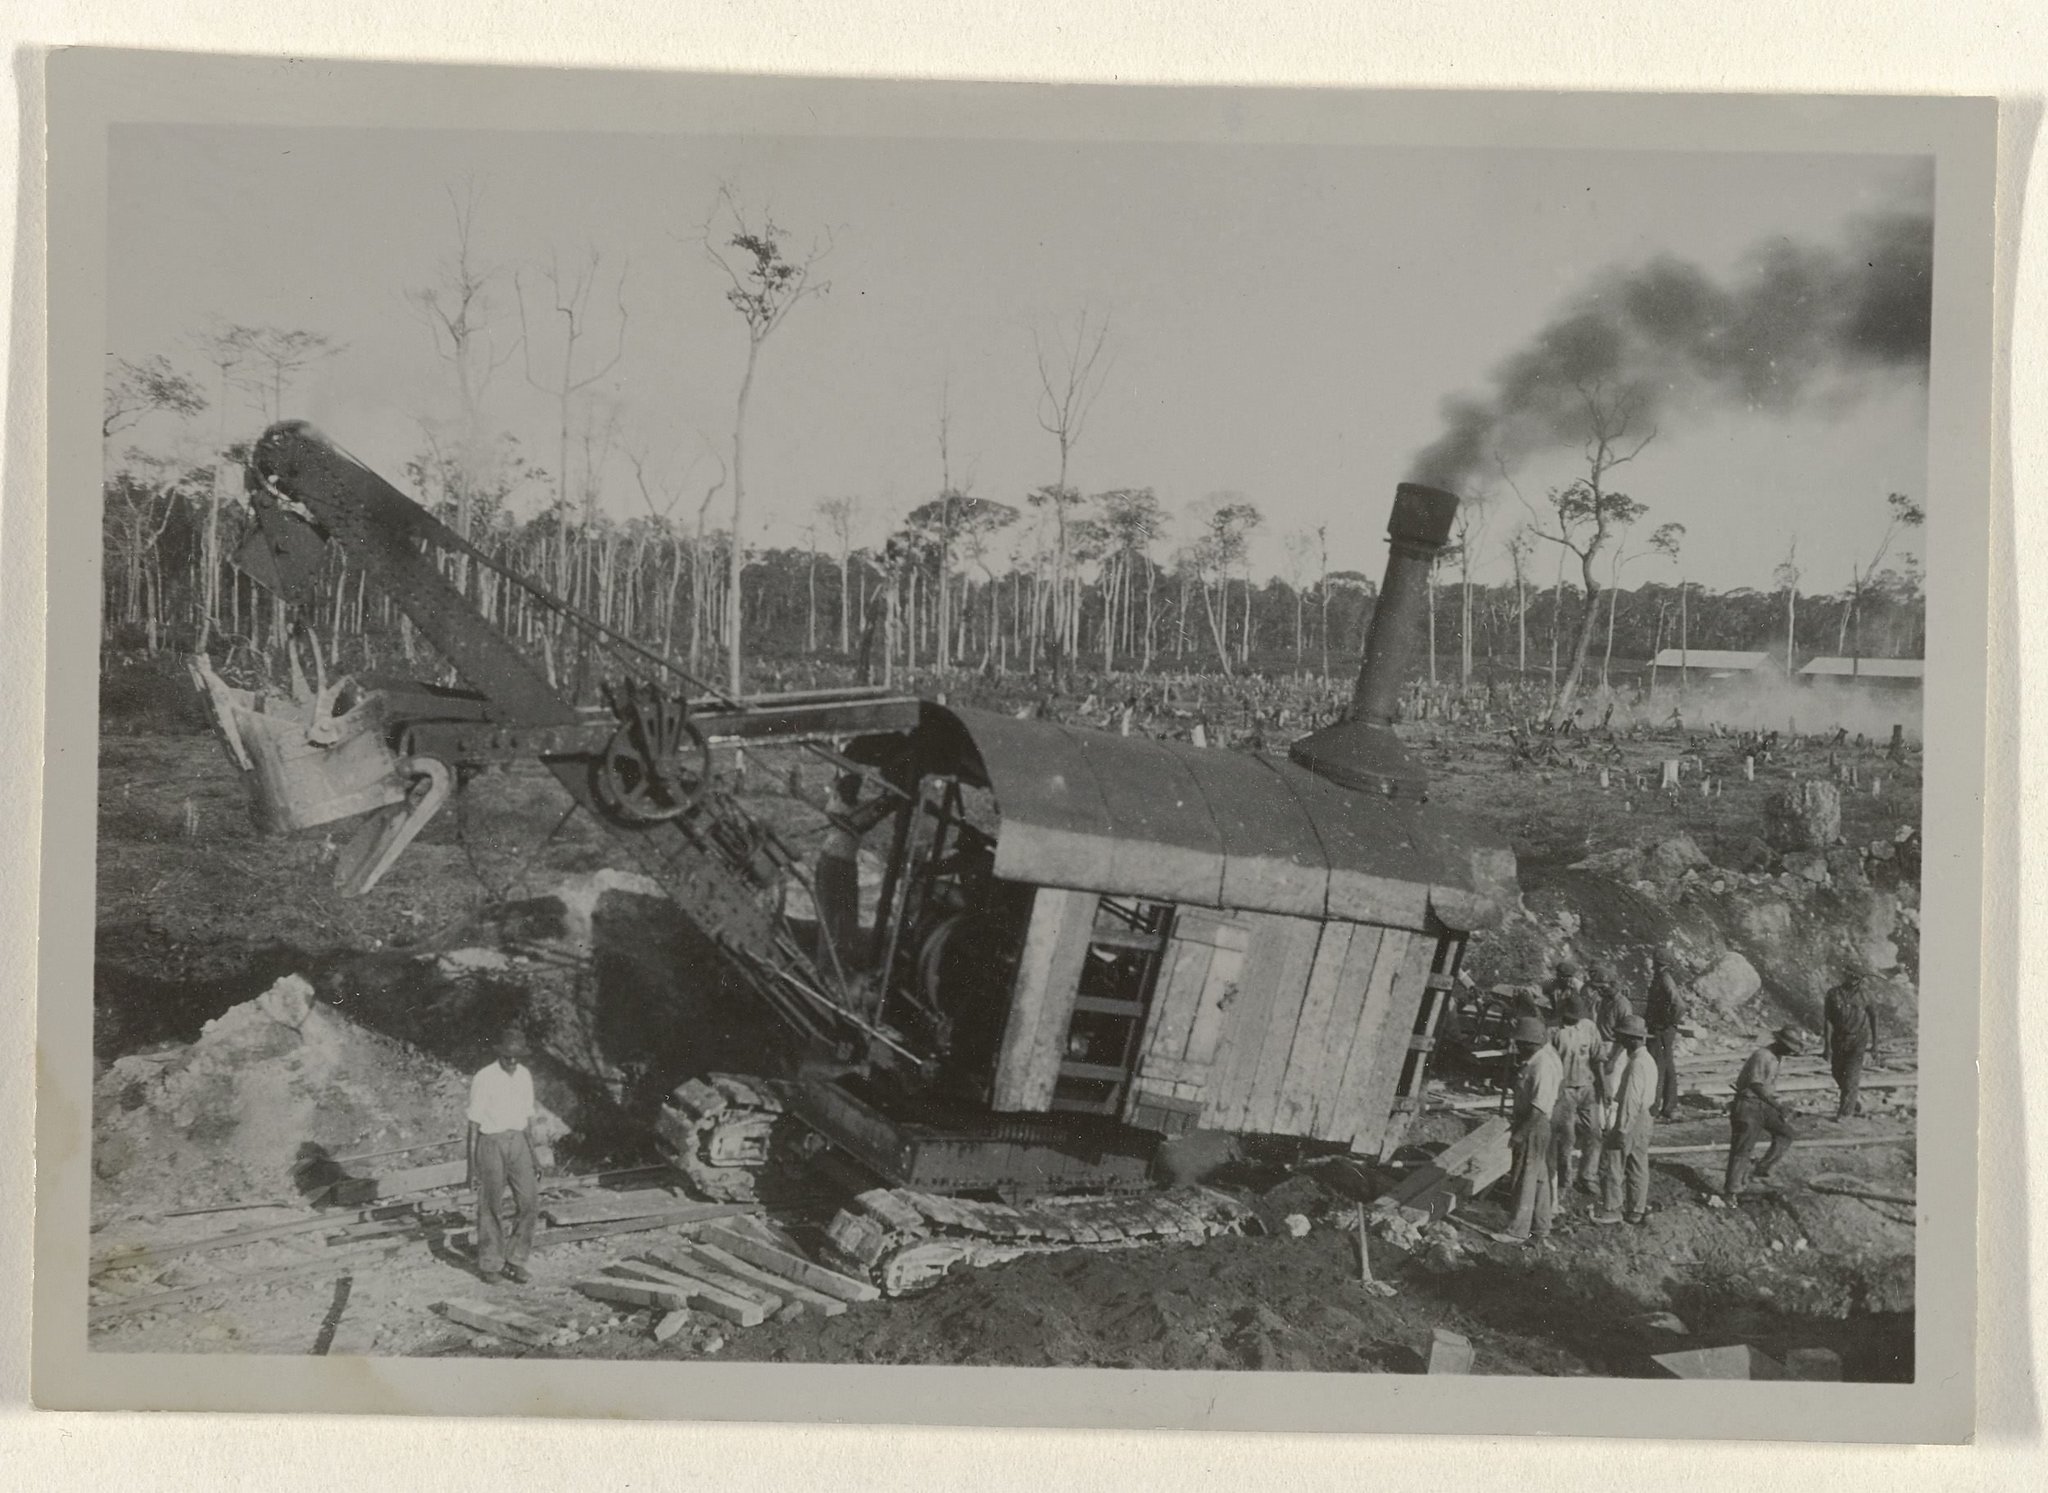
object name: photograph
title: Bauxiet wordt met een dragline vervoert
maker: Anonymous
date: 1929-1930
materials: photographic support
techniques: gelatin silver print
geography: suriname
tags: opencast mine; strip mining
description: De dragline zal vervolgens de bauxiet in lorries storten om zo het bauxiet te transporteren naar de bauxietfabriek.